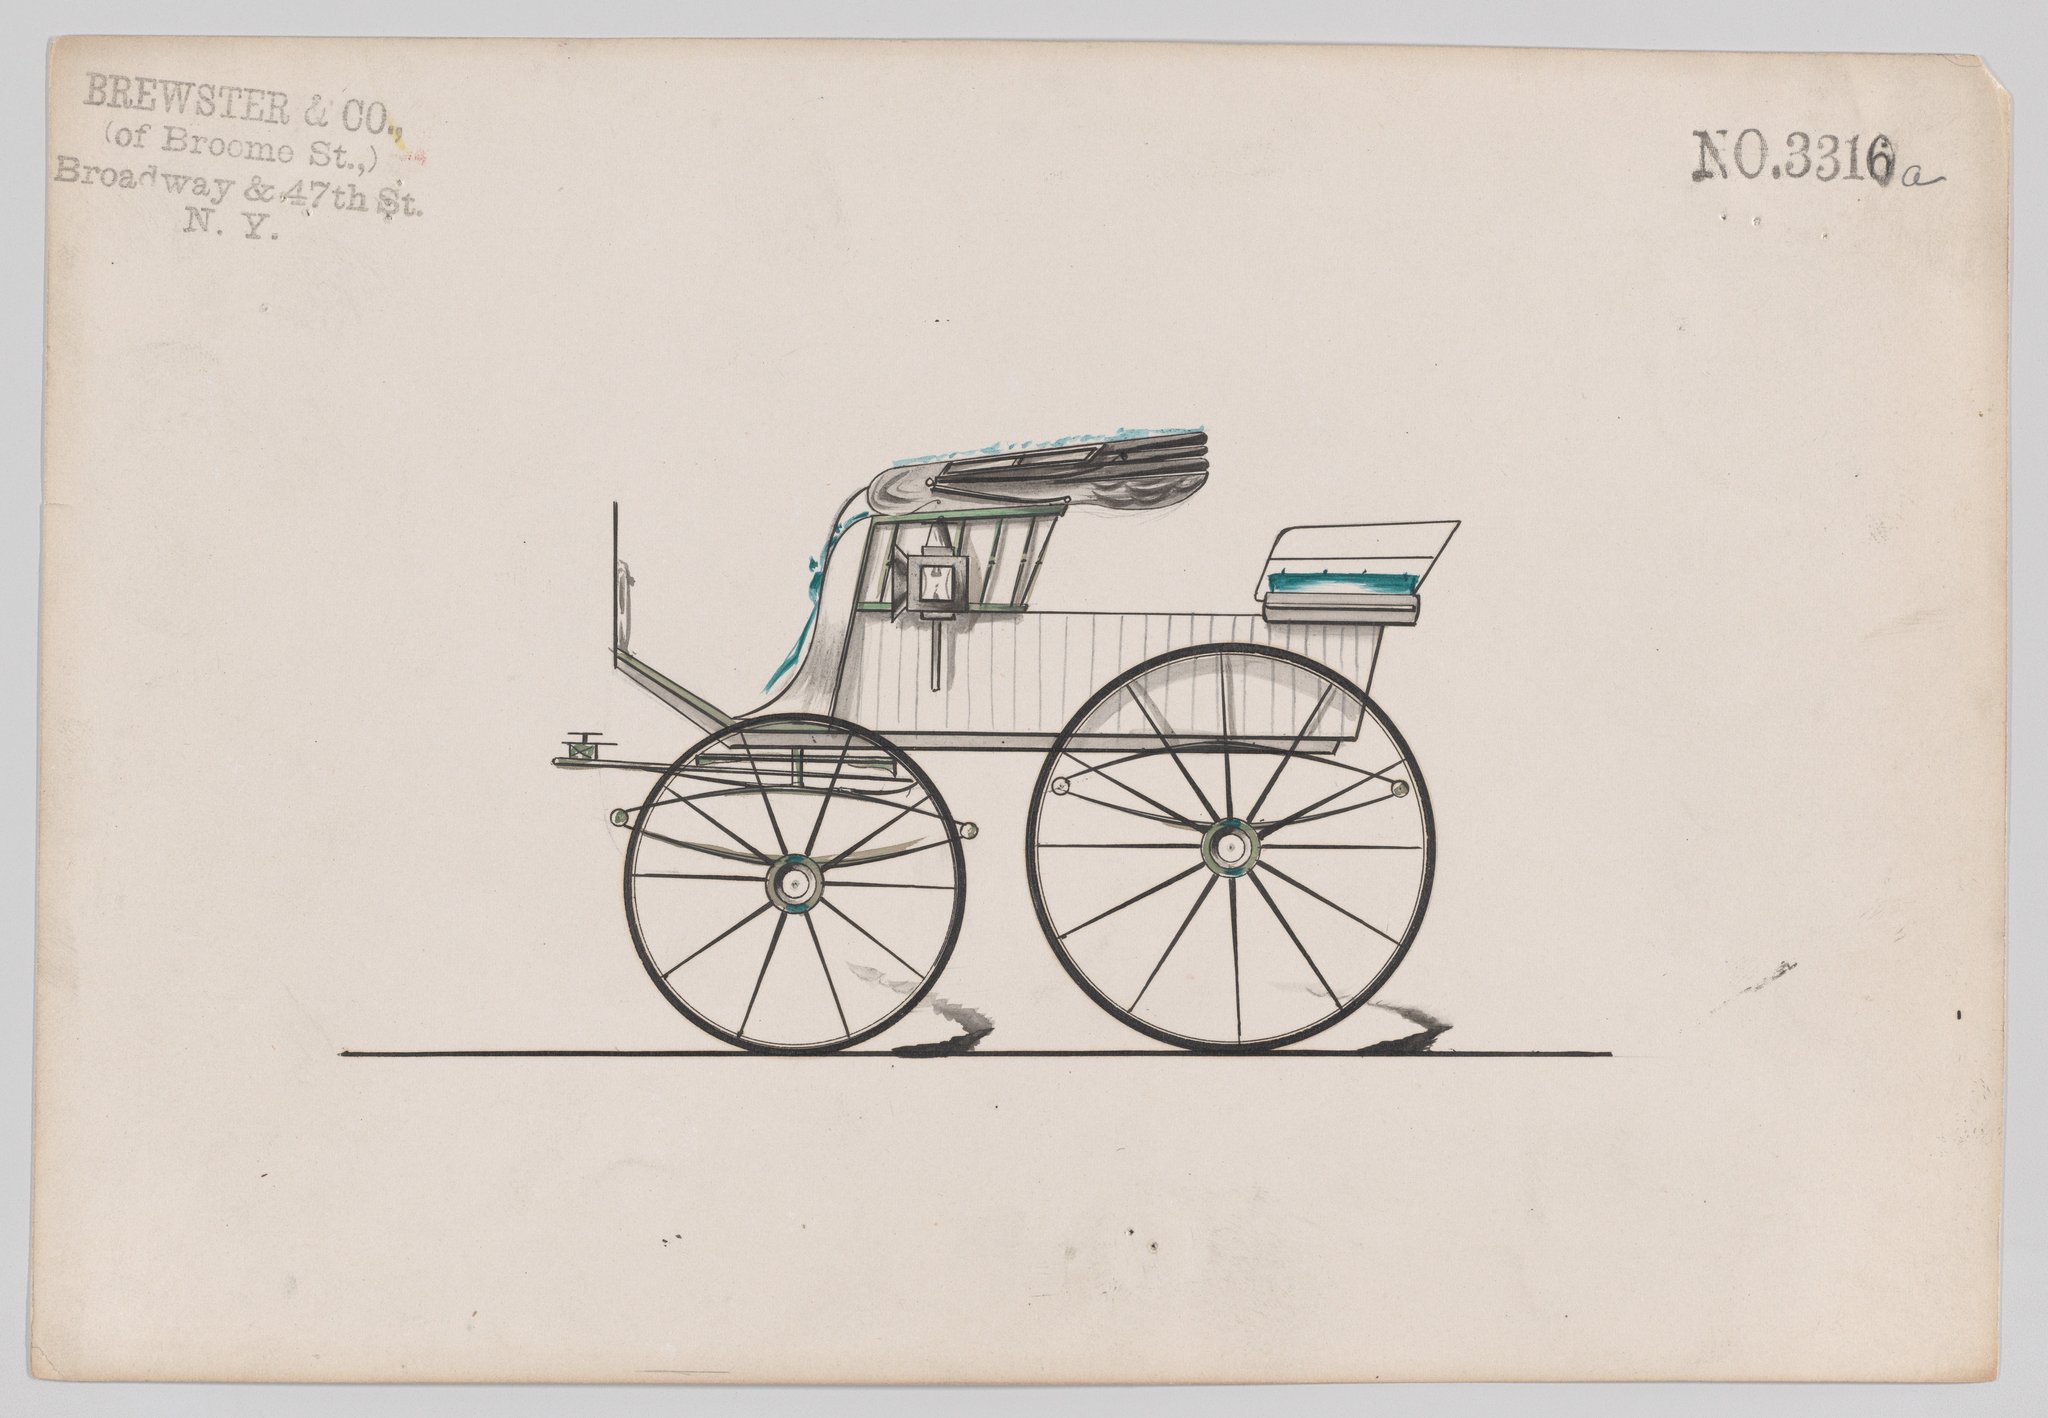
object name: drawing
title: Design for Stanhope Phaeton, no. 3316a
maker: brewster & co.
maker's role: manufacturer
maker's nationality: american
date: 1877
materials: gouache, ink, watercolor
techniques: pen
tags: carriages